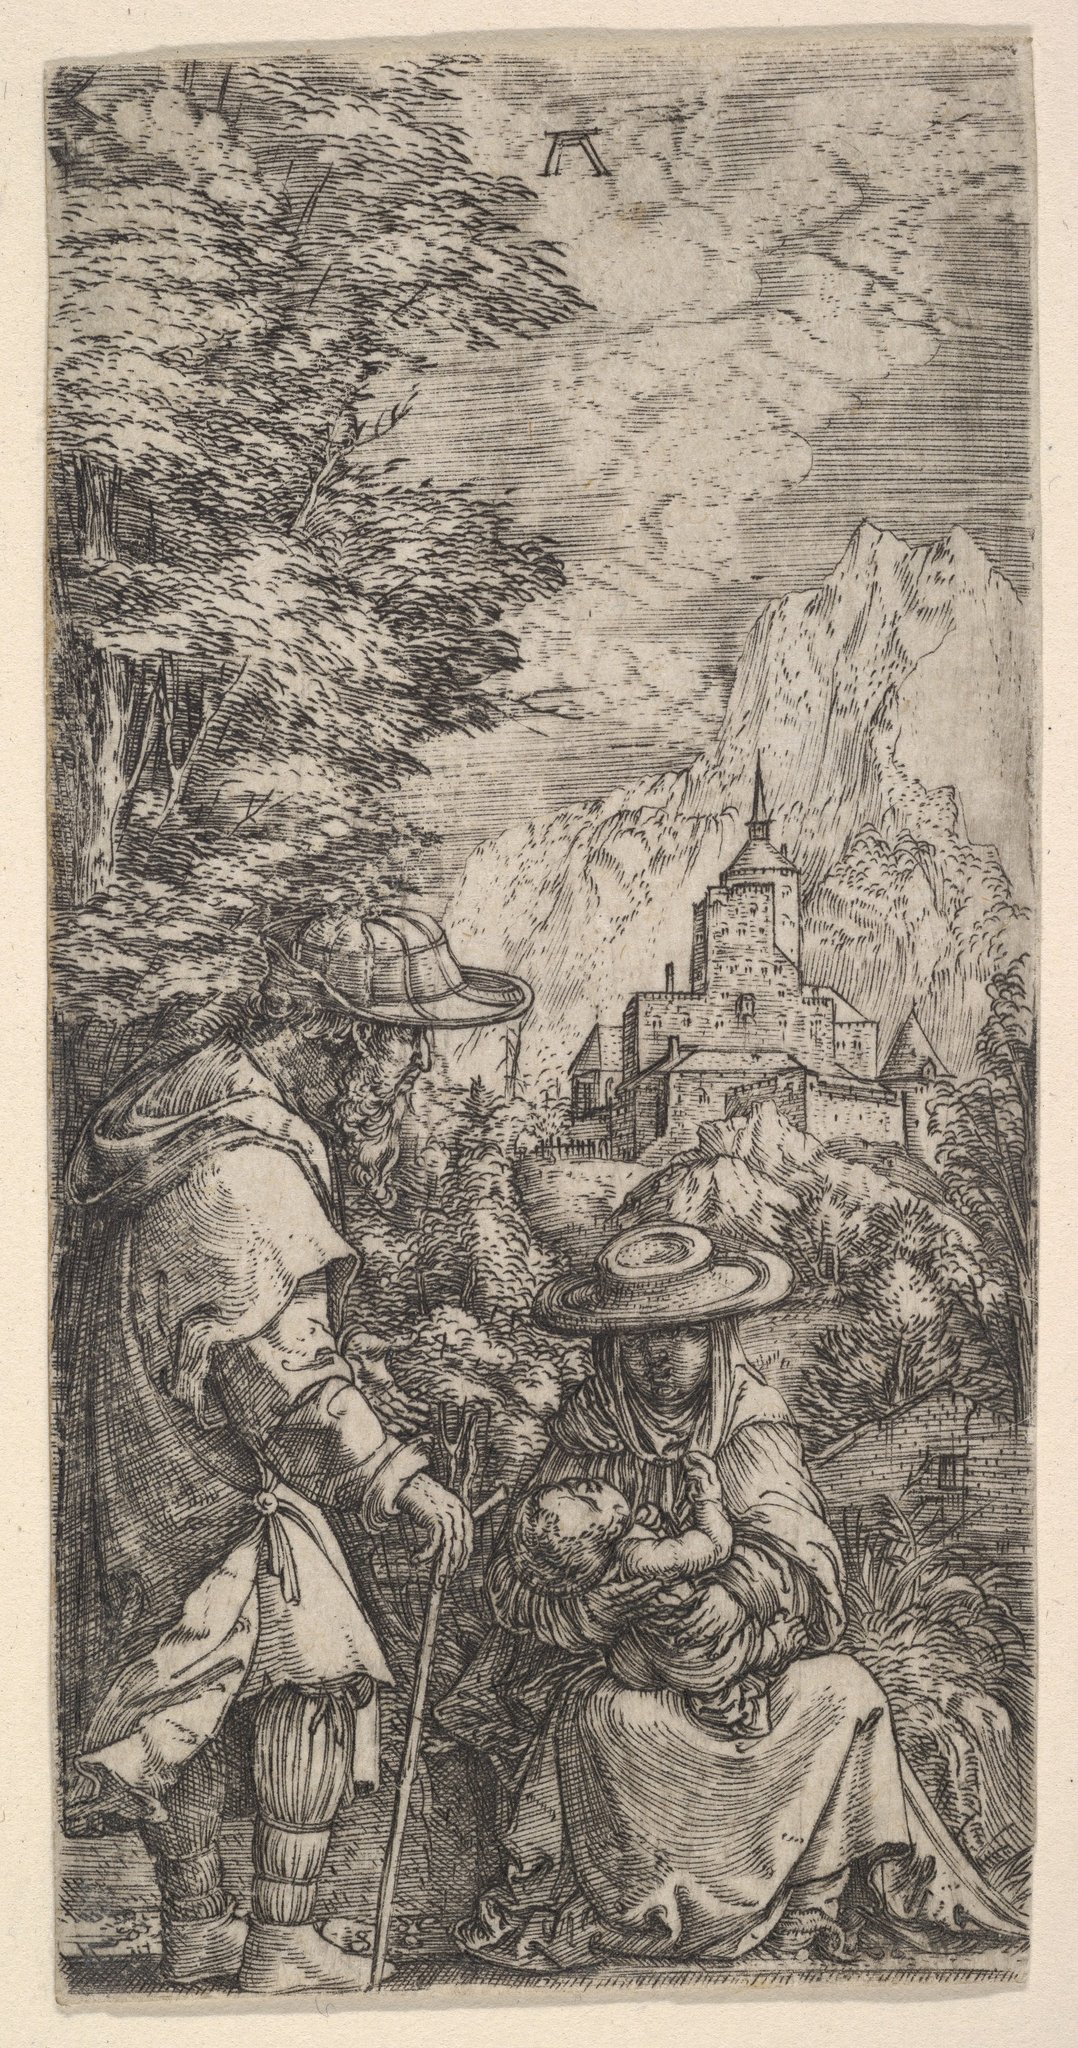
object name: print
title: The Rest on the Flight into Egypt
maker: albrecht altdorfer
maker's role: artist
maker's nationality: german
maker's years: 1480-1538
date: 1500-1538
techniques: engraving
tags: holy family